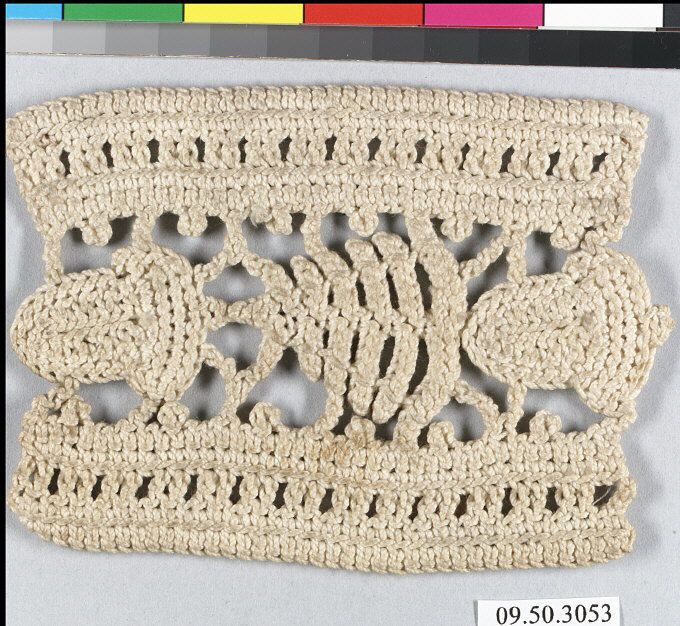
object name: sample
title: Crochet Work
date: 1801-1900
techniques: crochet